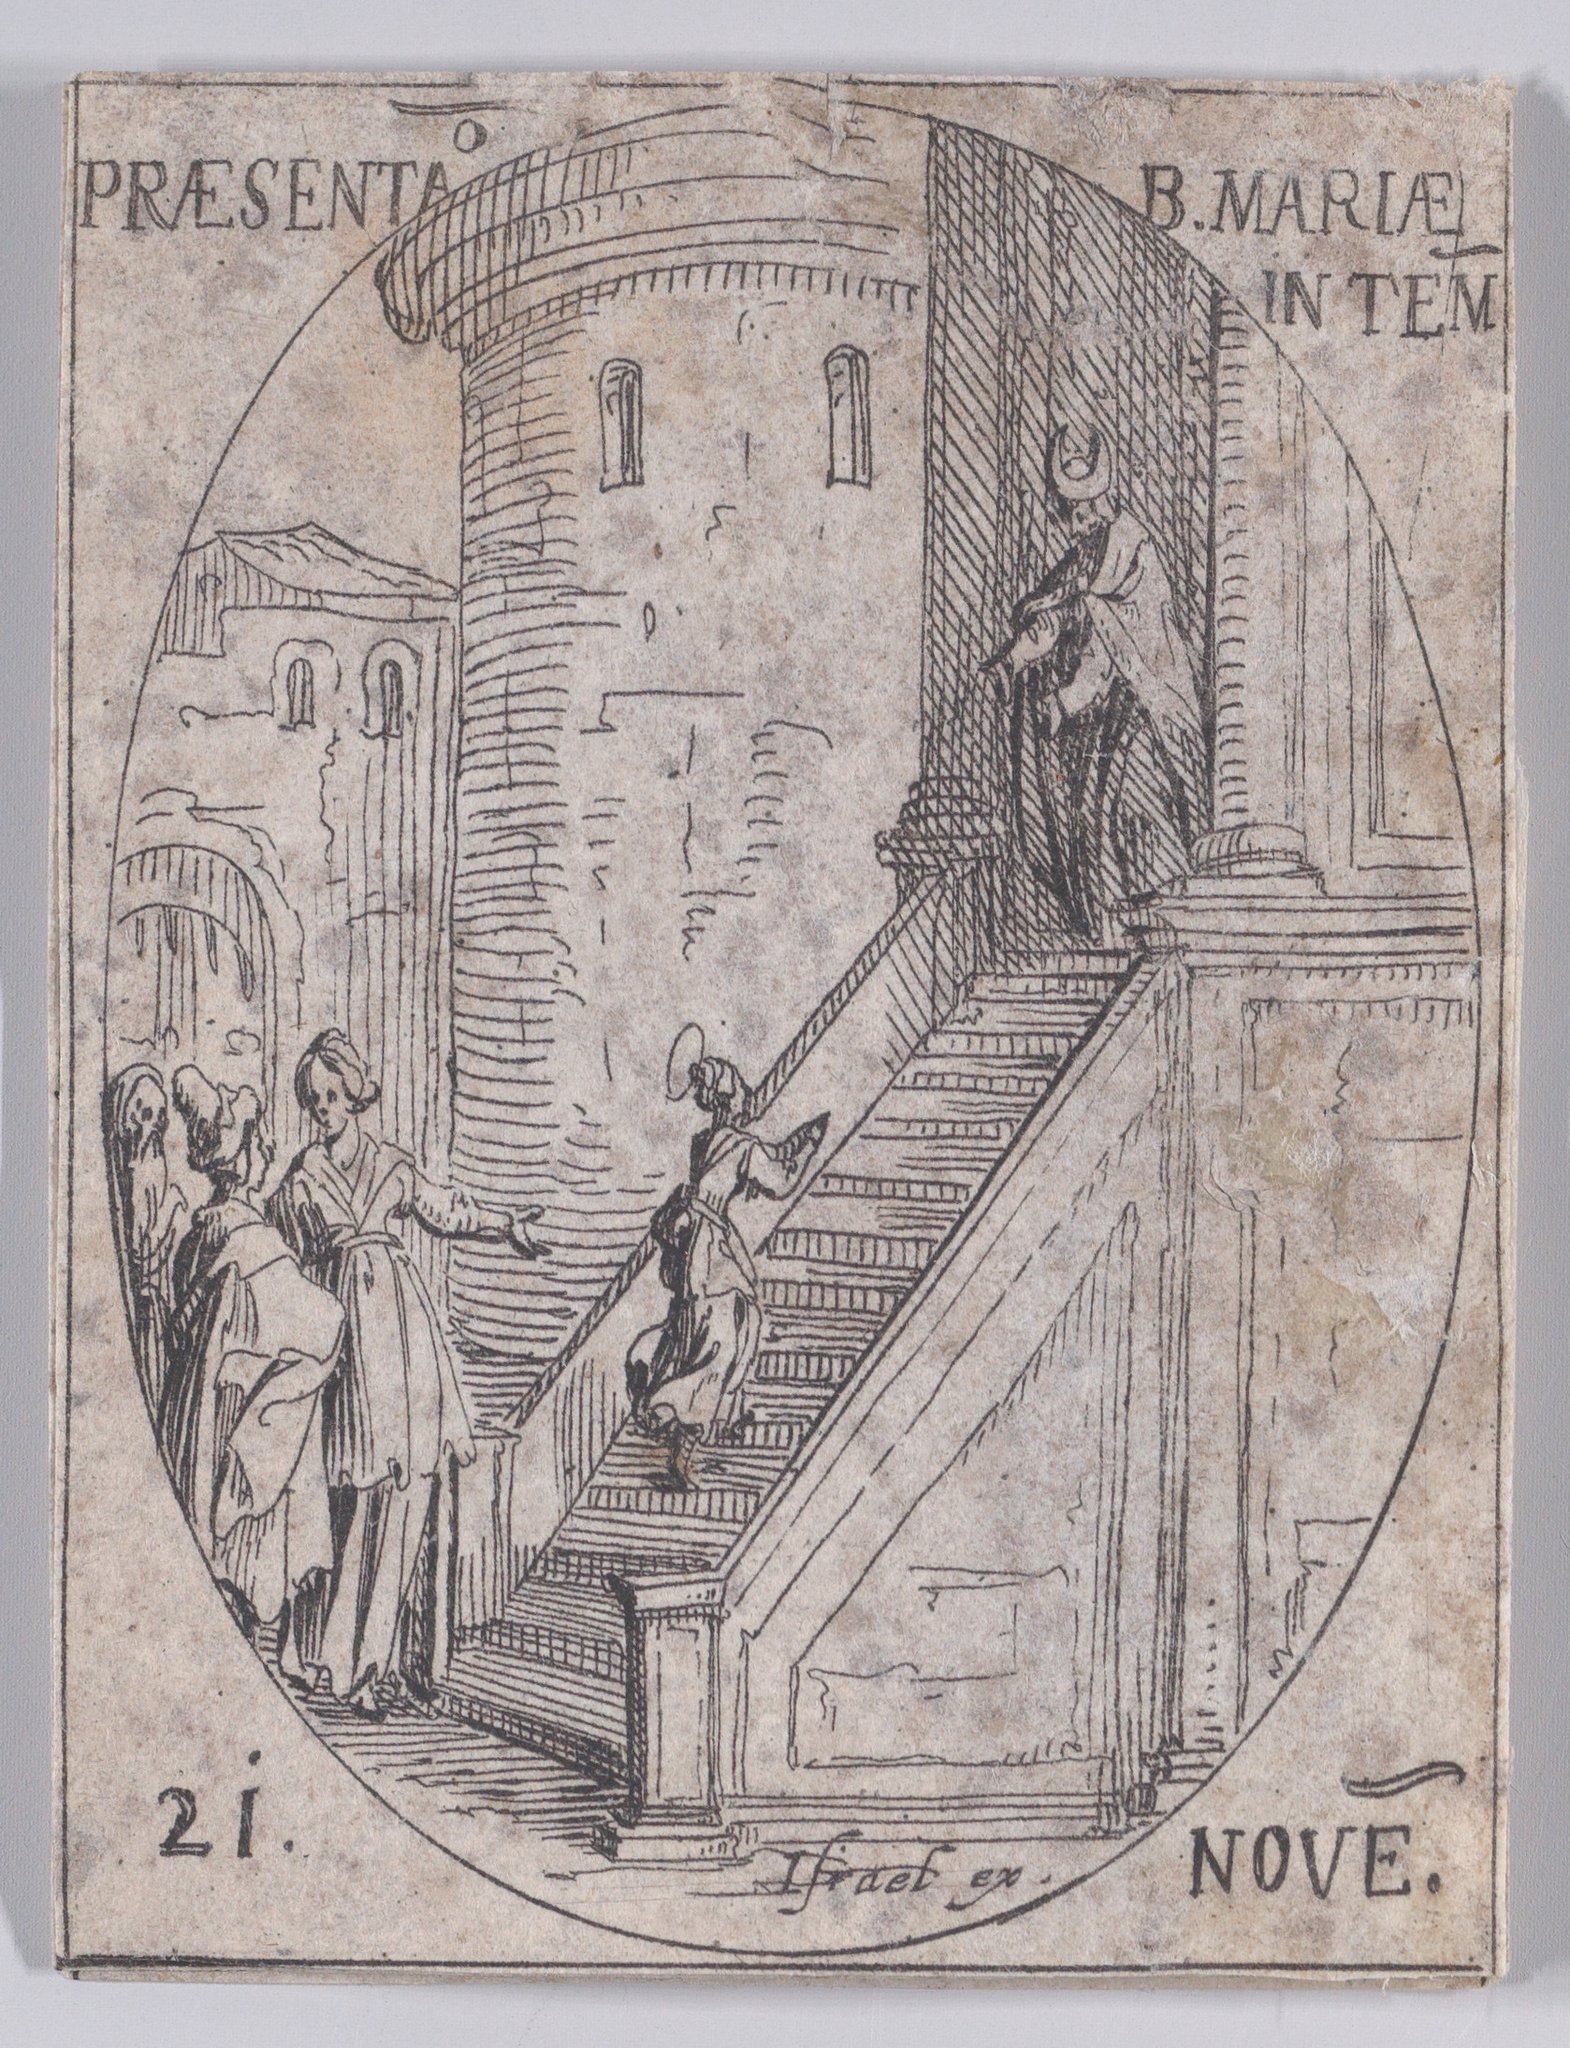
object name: print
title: Preséntation de la Vierge Marie dans le Temple (Presentation of the Virgin Mary in the Temple), November 21st, from "Les Images De Tous Les Saincts et Saintes de L'Année" (Images of All of the Saints and Religious Events of the Year)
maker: jacques callot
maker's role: artist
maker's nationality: french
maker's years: 1592-1635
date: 1636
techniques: etching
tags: temples,virgin mary